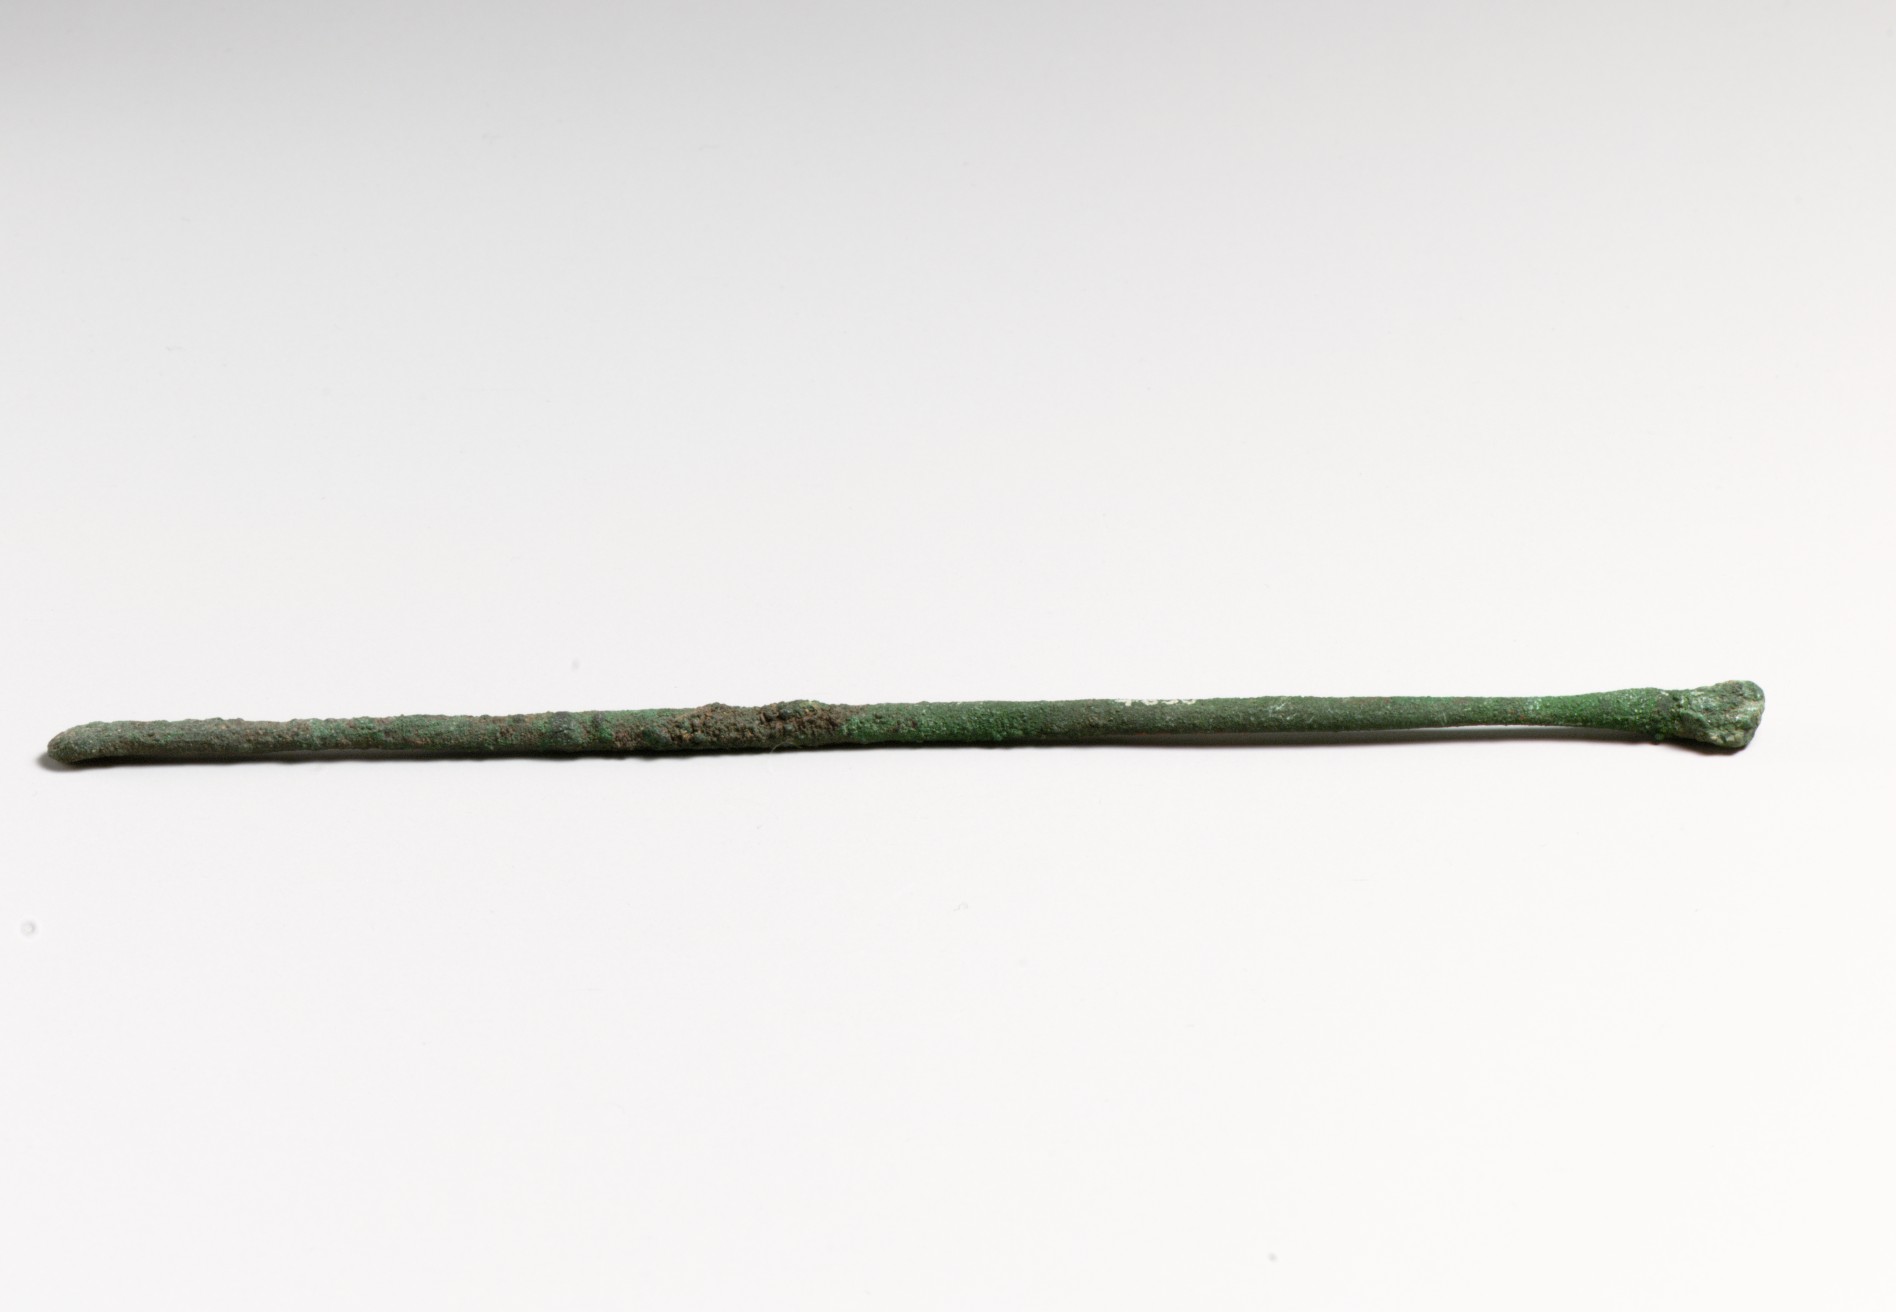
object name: spoon probe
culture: cypriot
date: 3900 BCE-100 CE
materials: bronze